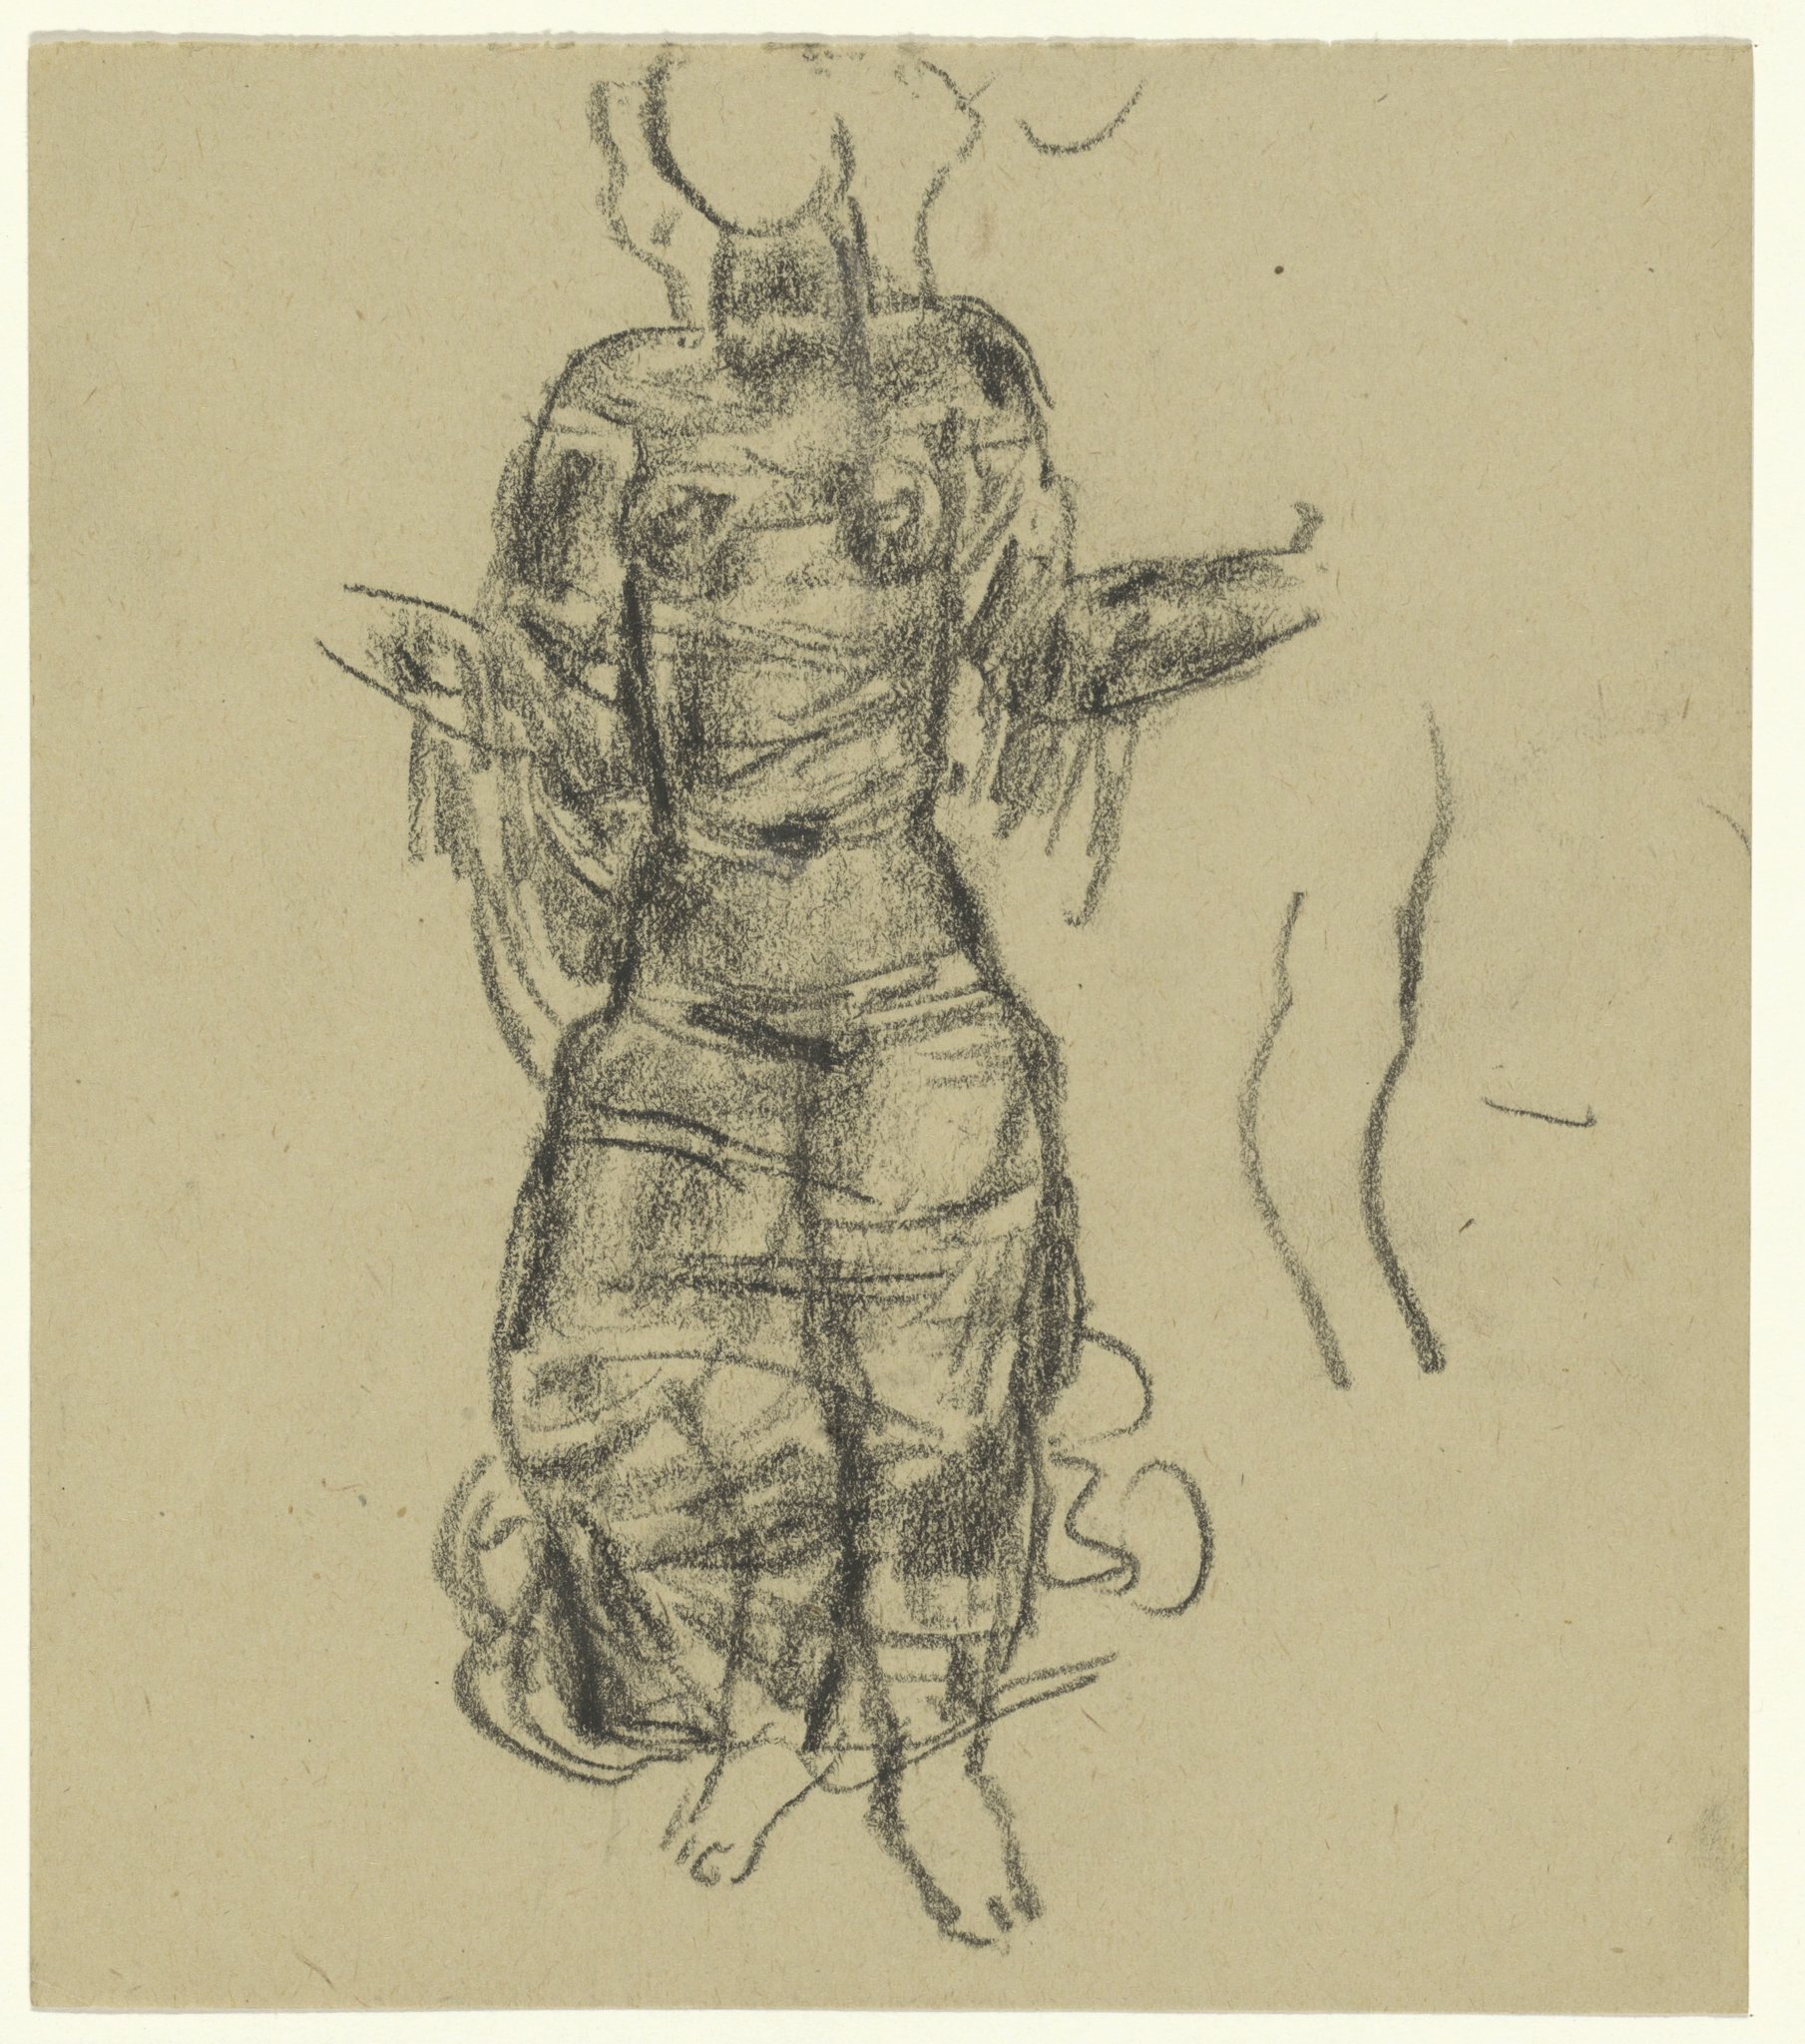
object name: drawing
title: Dansende vrouw in doorzichtige draperieën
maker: leo gestel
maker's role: draughtsman, print maker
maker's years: 1881-1941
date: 1891-1941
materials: chalk, paper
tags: female sex; woman, drapery, draped garment, 'gewandgebung'